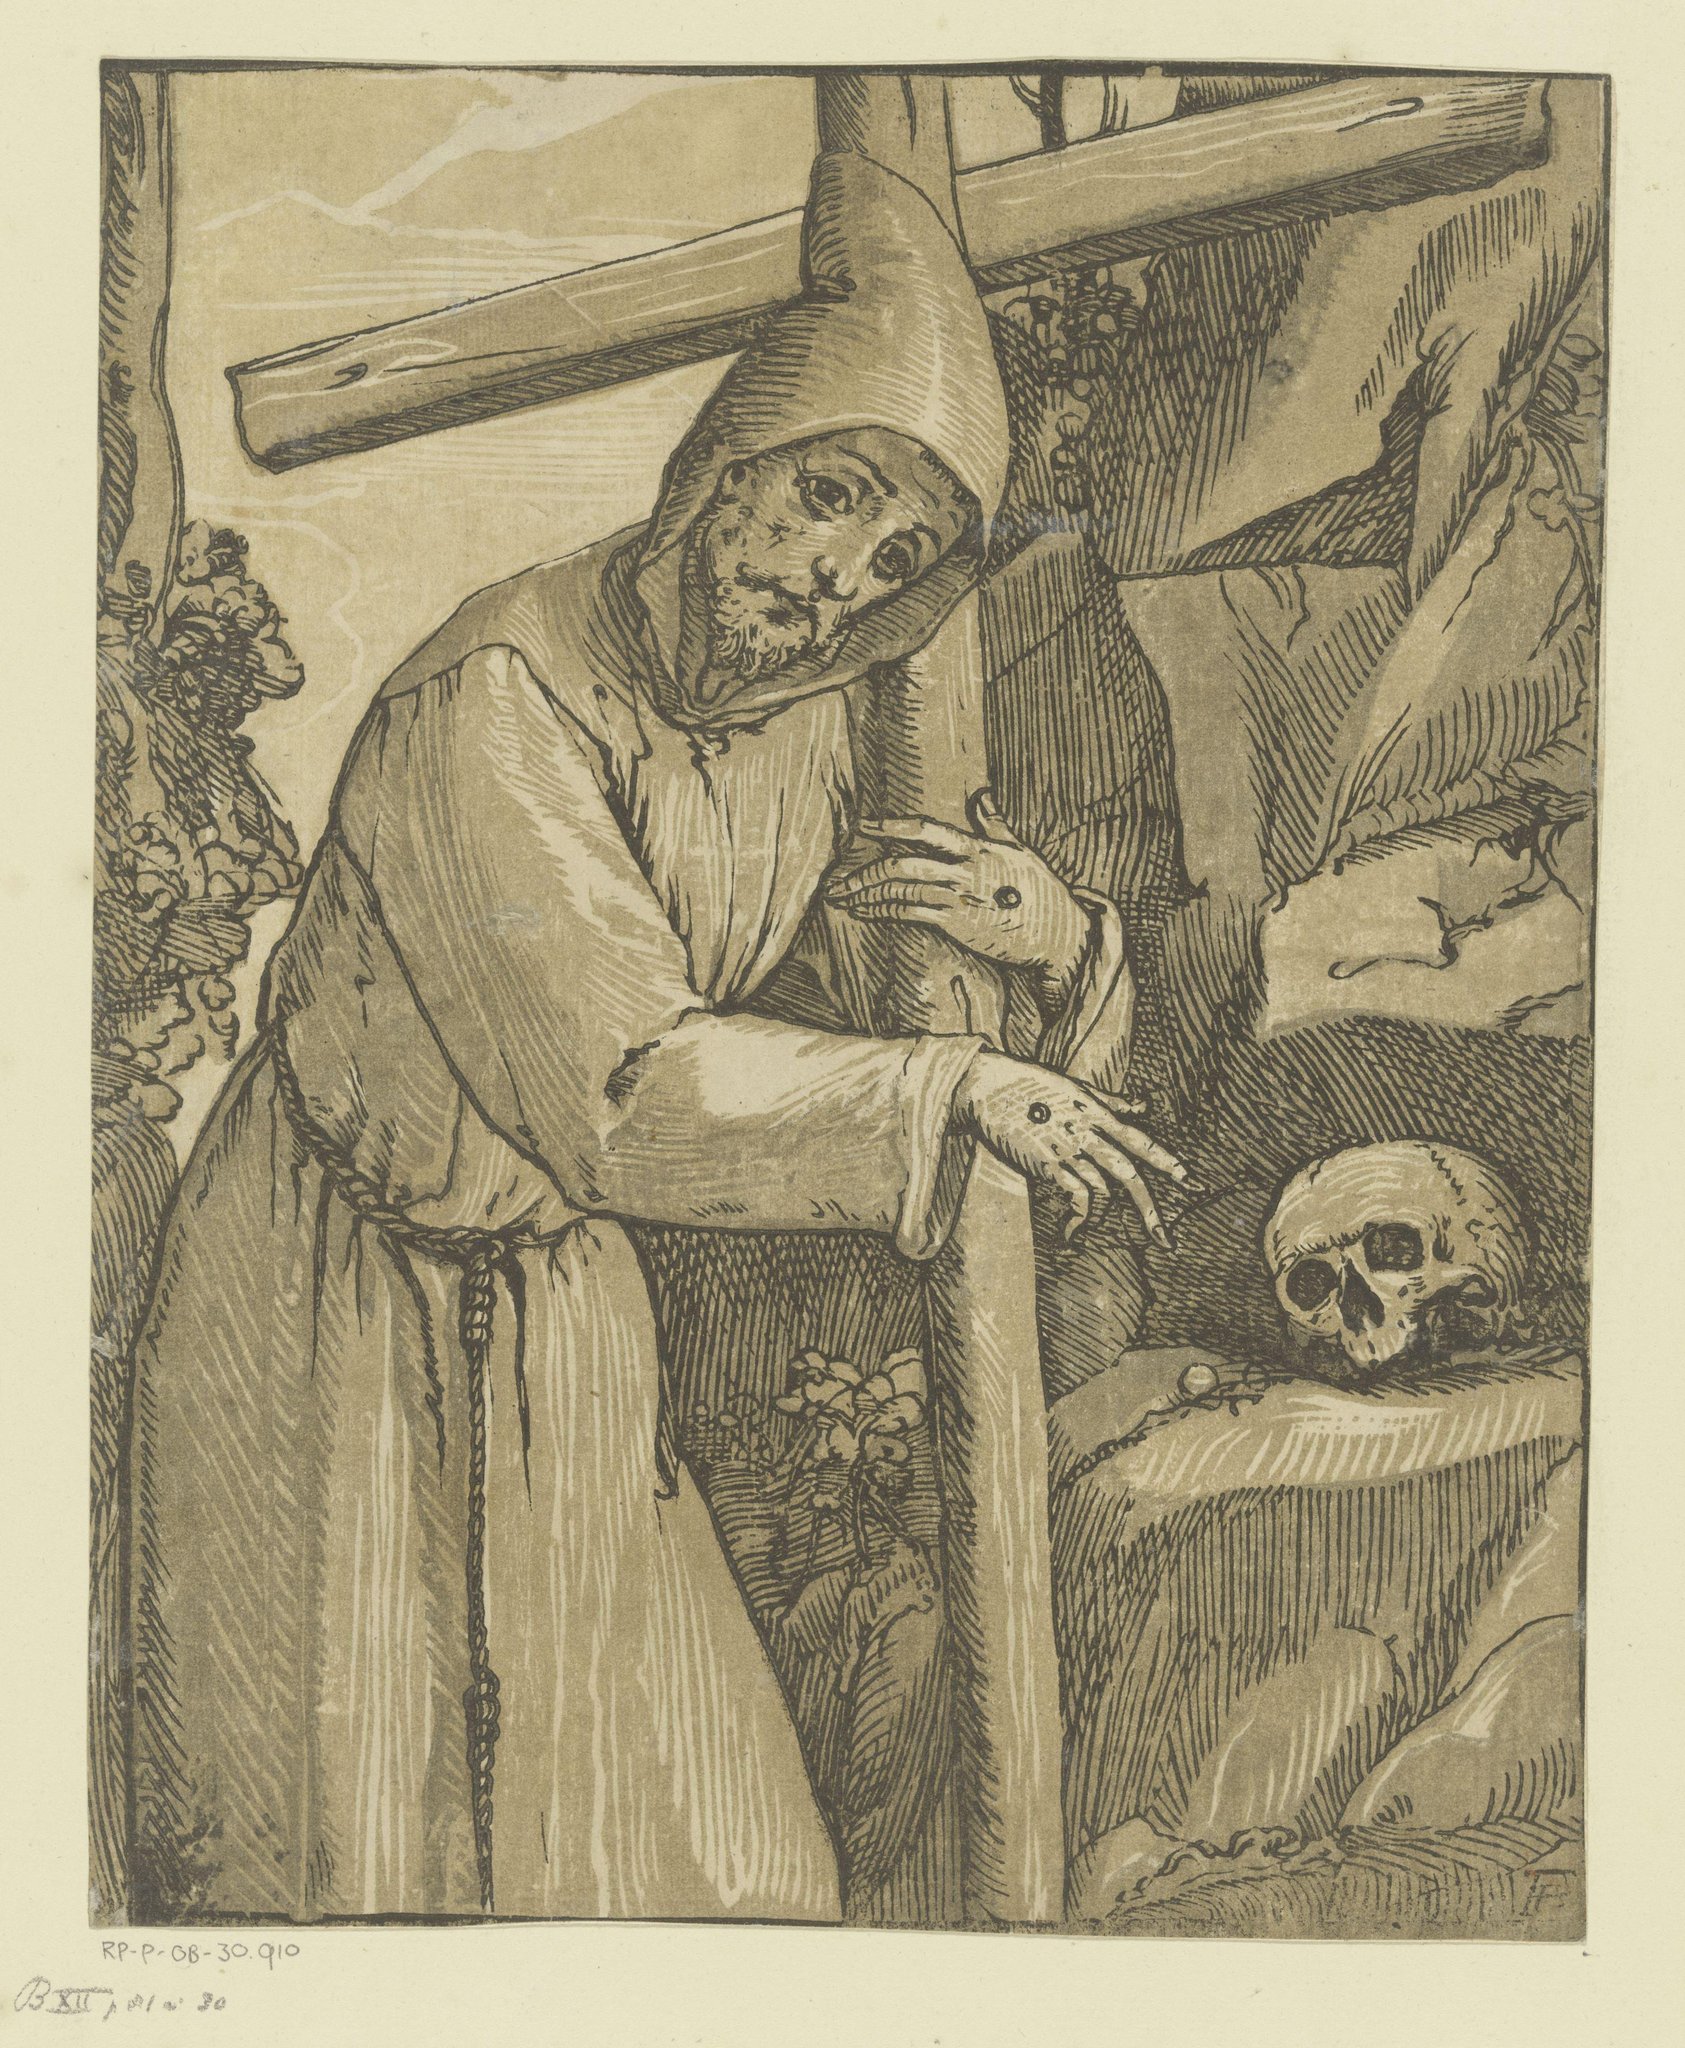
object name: print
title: Heilige Franciscus van Assisi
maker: andrea andreani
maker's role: print maker, printer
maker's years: 1558-1629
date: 1591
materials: paper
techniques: woodcut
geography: italy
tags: founder of the order of friars minor (franciscans), francis(cus) of assisi; possible attributes: book, crucifix, lily, skull, stigmata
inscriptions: collector's mark: Lugt 240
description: De heilige Franciscus van Assisi met kruis. Op zijn handen zijn de stigmata zichtbaar. Rechts op de rotsen ligt een doodskop.